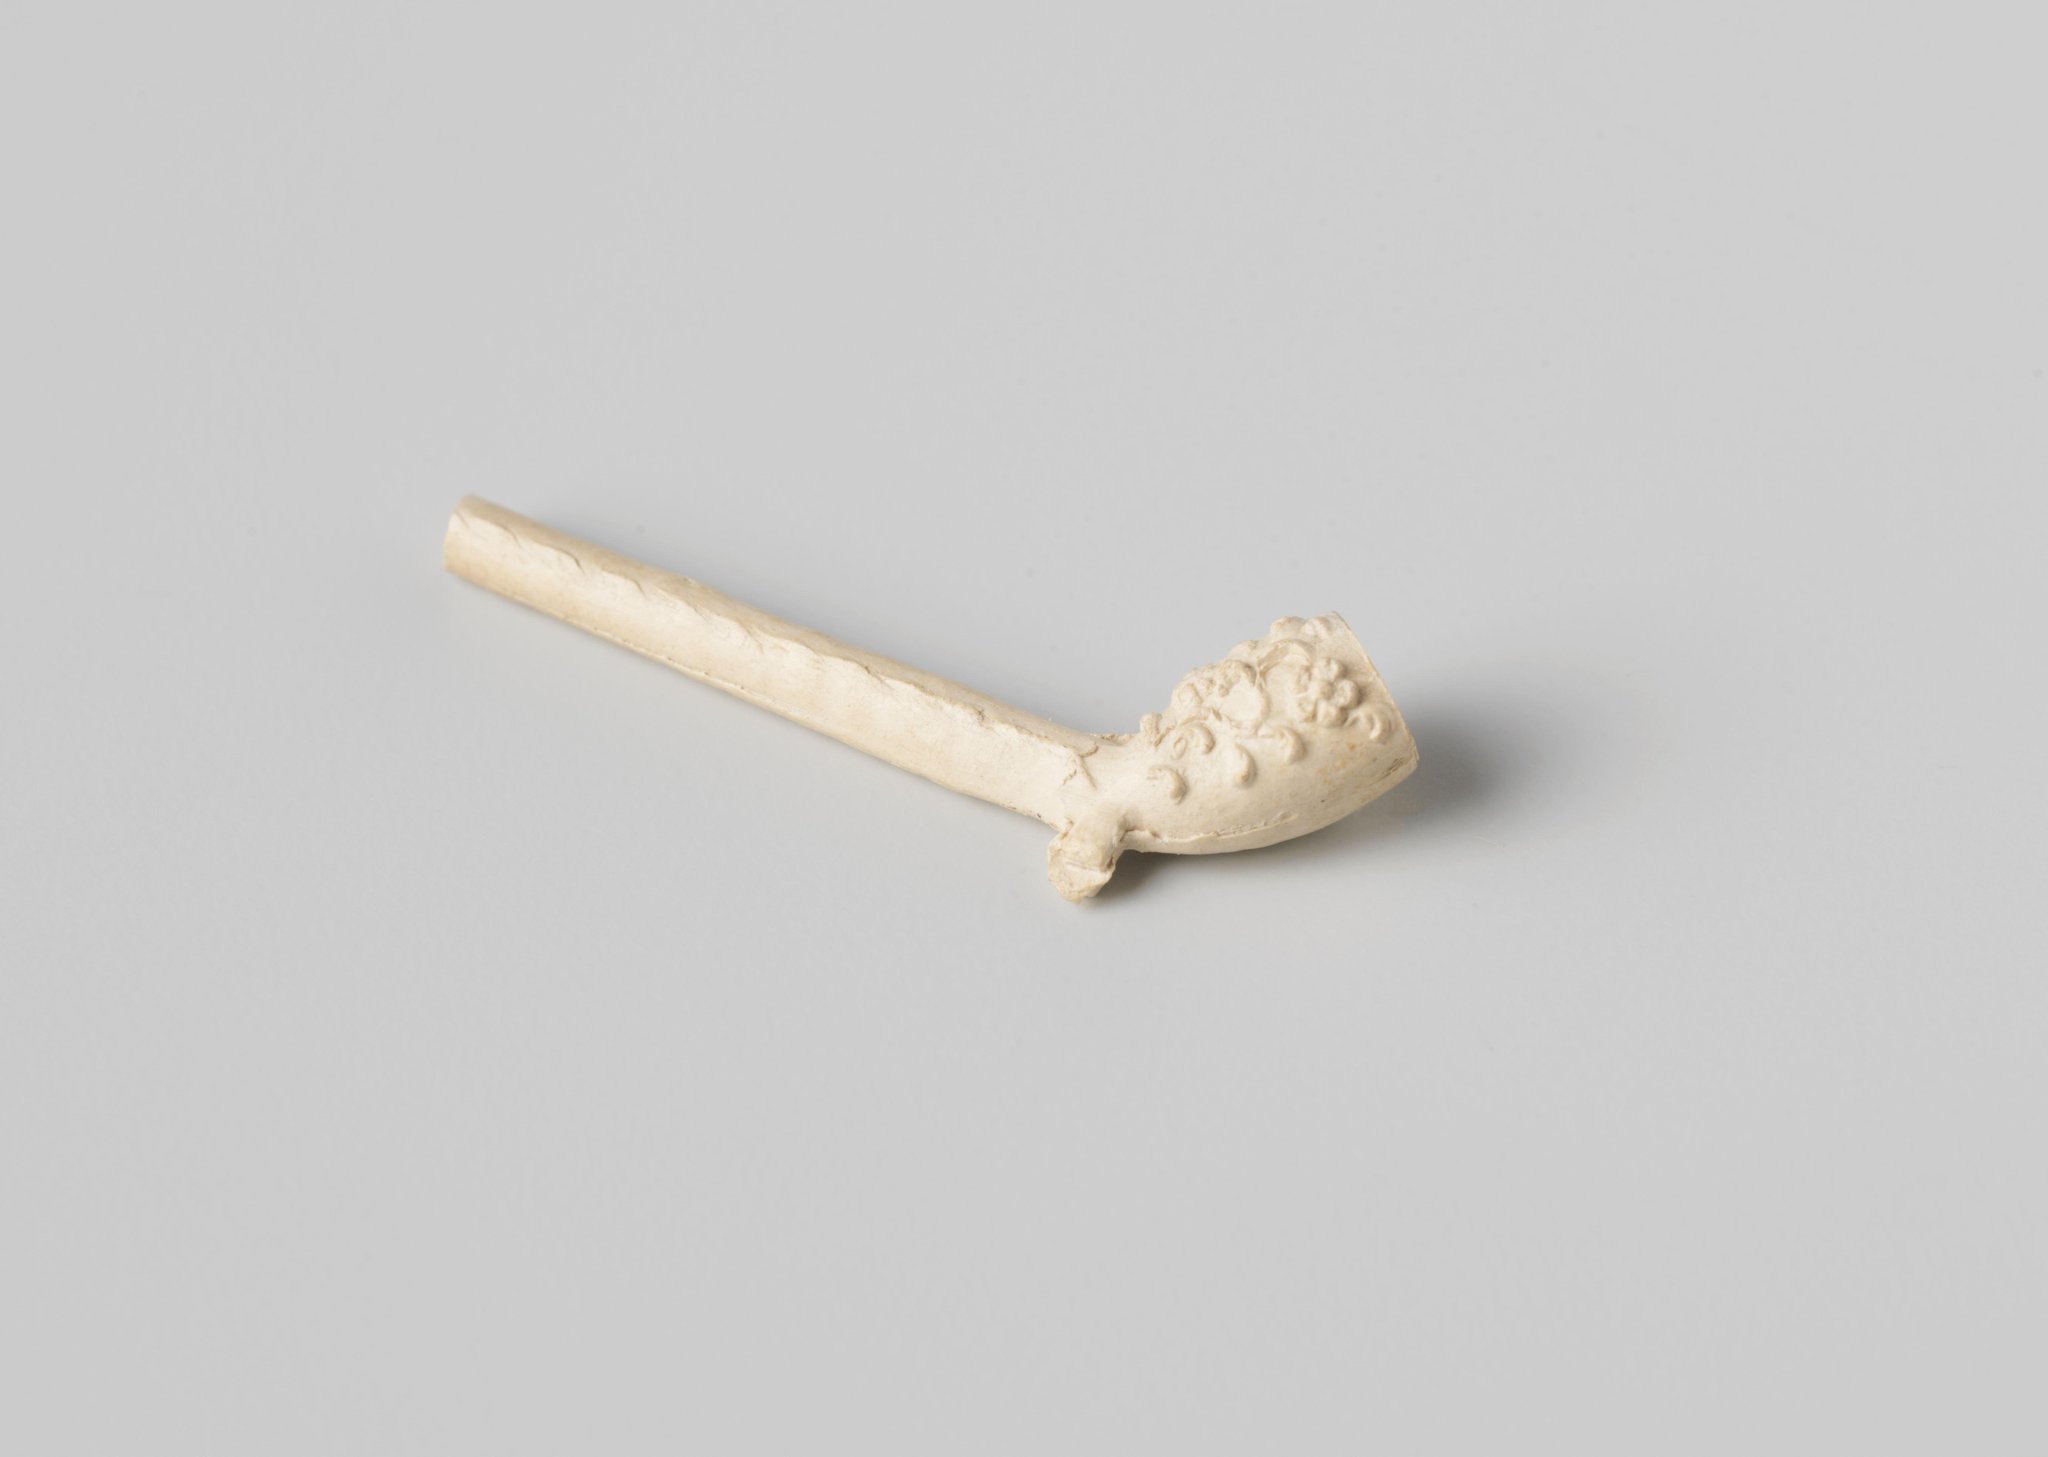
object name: miniature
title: Pijp, de kop versierd met bloemmotieven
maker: Anonymous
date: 1700-1799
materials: clay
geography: gouda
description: Pijp van witte pijpaarde, de kop versierd met fijne bloemmotieven.